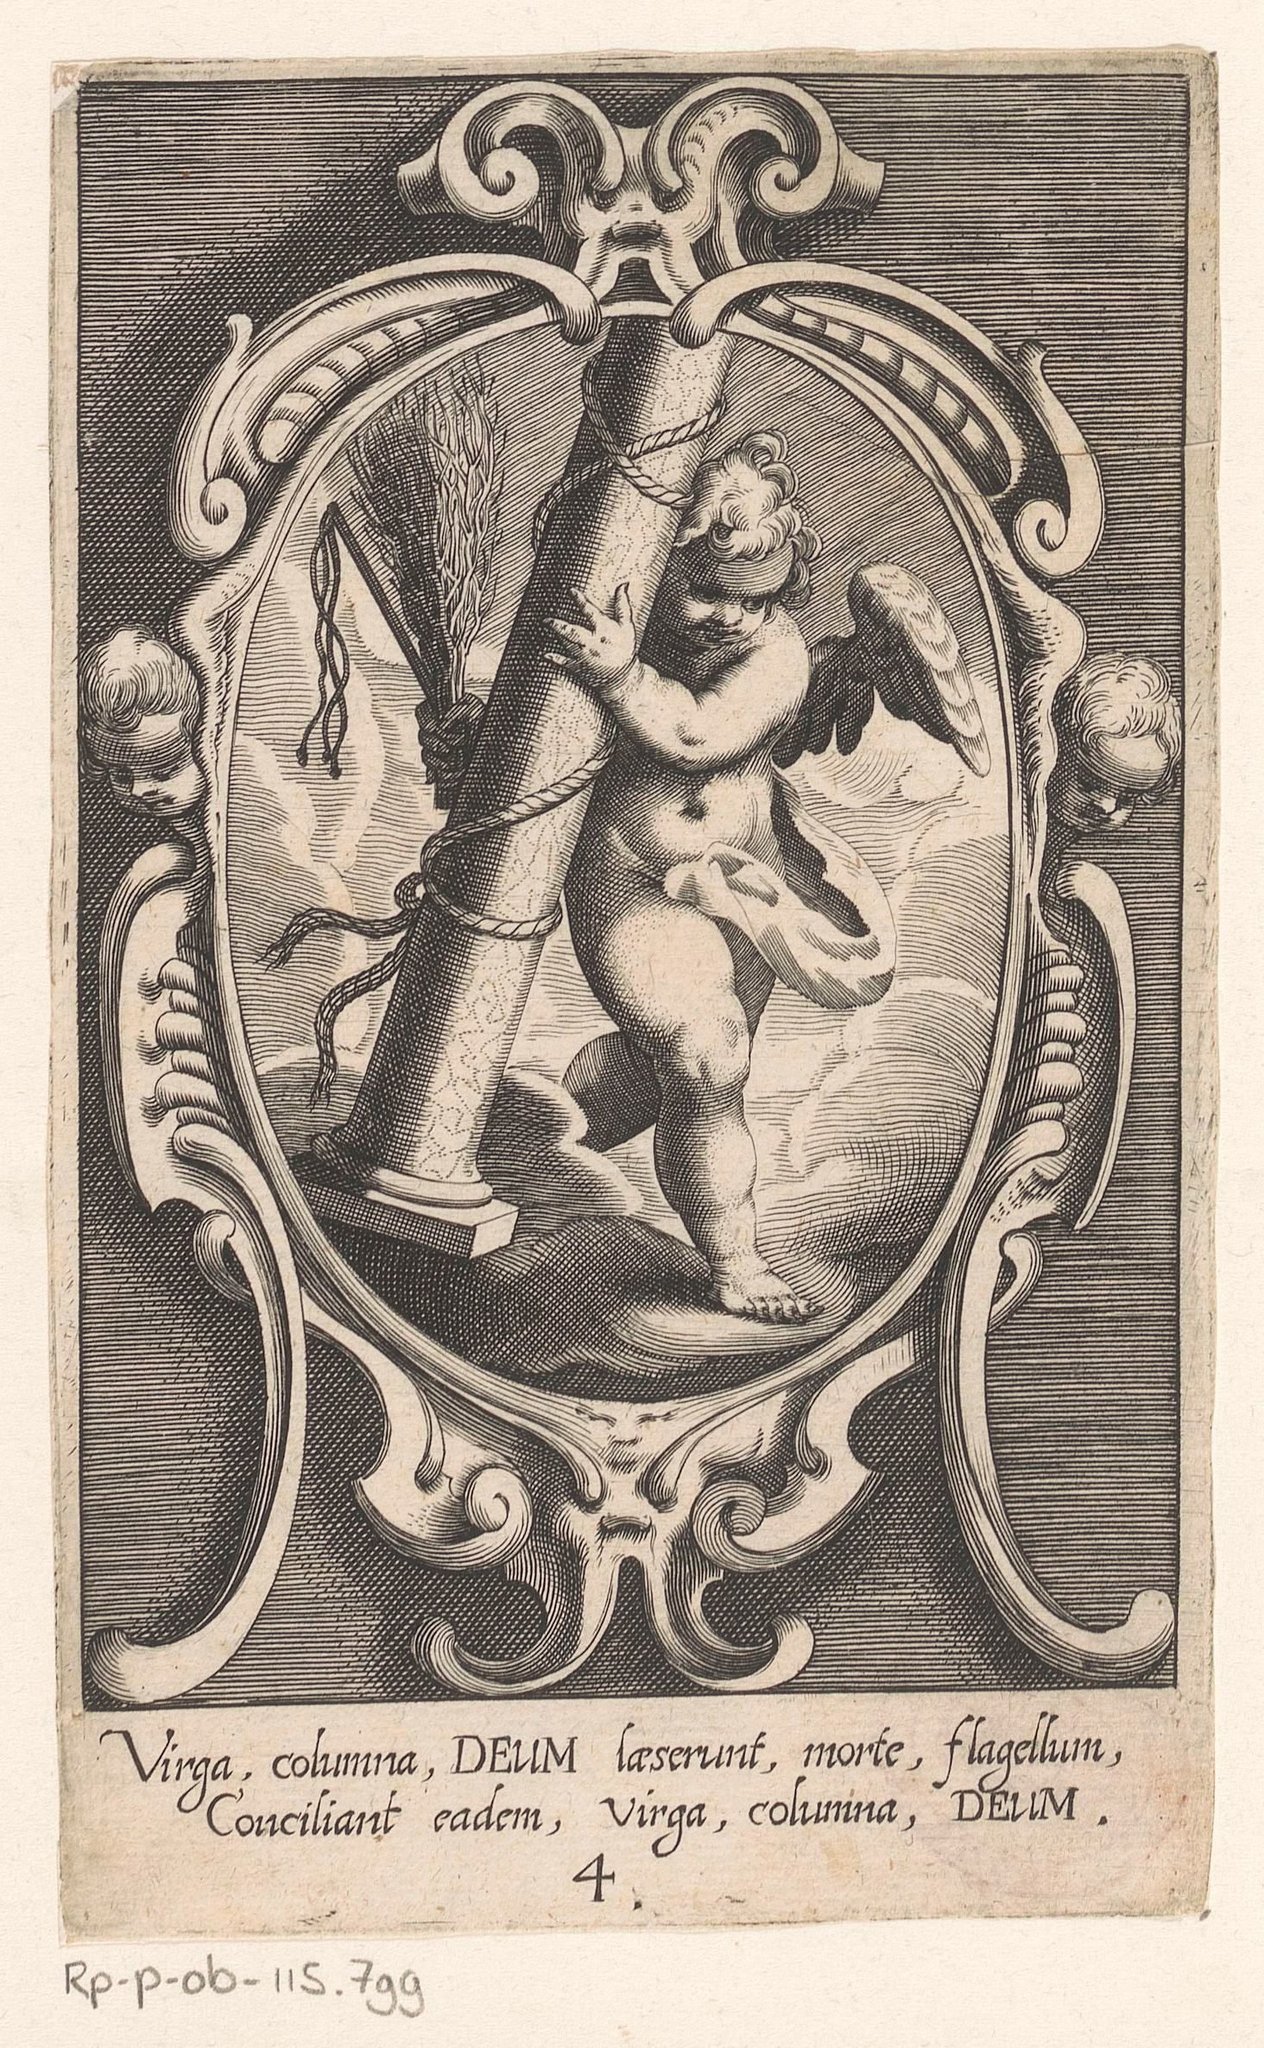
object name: print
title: Emblemata Sacra Passionis Salvatoris nostri Jesu Christi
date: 1620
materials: paper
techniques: engraving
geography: augsburg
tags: column (of the flagellation) ~ instruments of the passion, 'arma christi'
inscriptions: collector's mark: Lugt 240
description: Serie bevattende een titelprent en elf prenten van de passiewerktuigen. De prenten zijn genummerd van één tot en met twaalf. Nummer tien is niet aanwezig in deze serie, evenals in de series genoemd in de referentielitertuur.